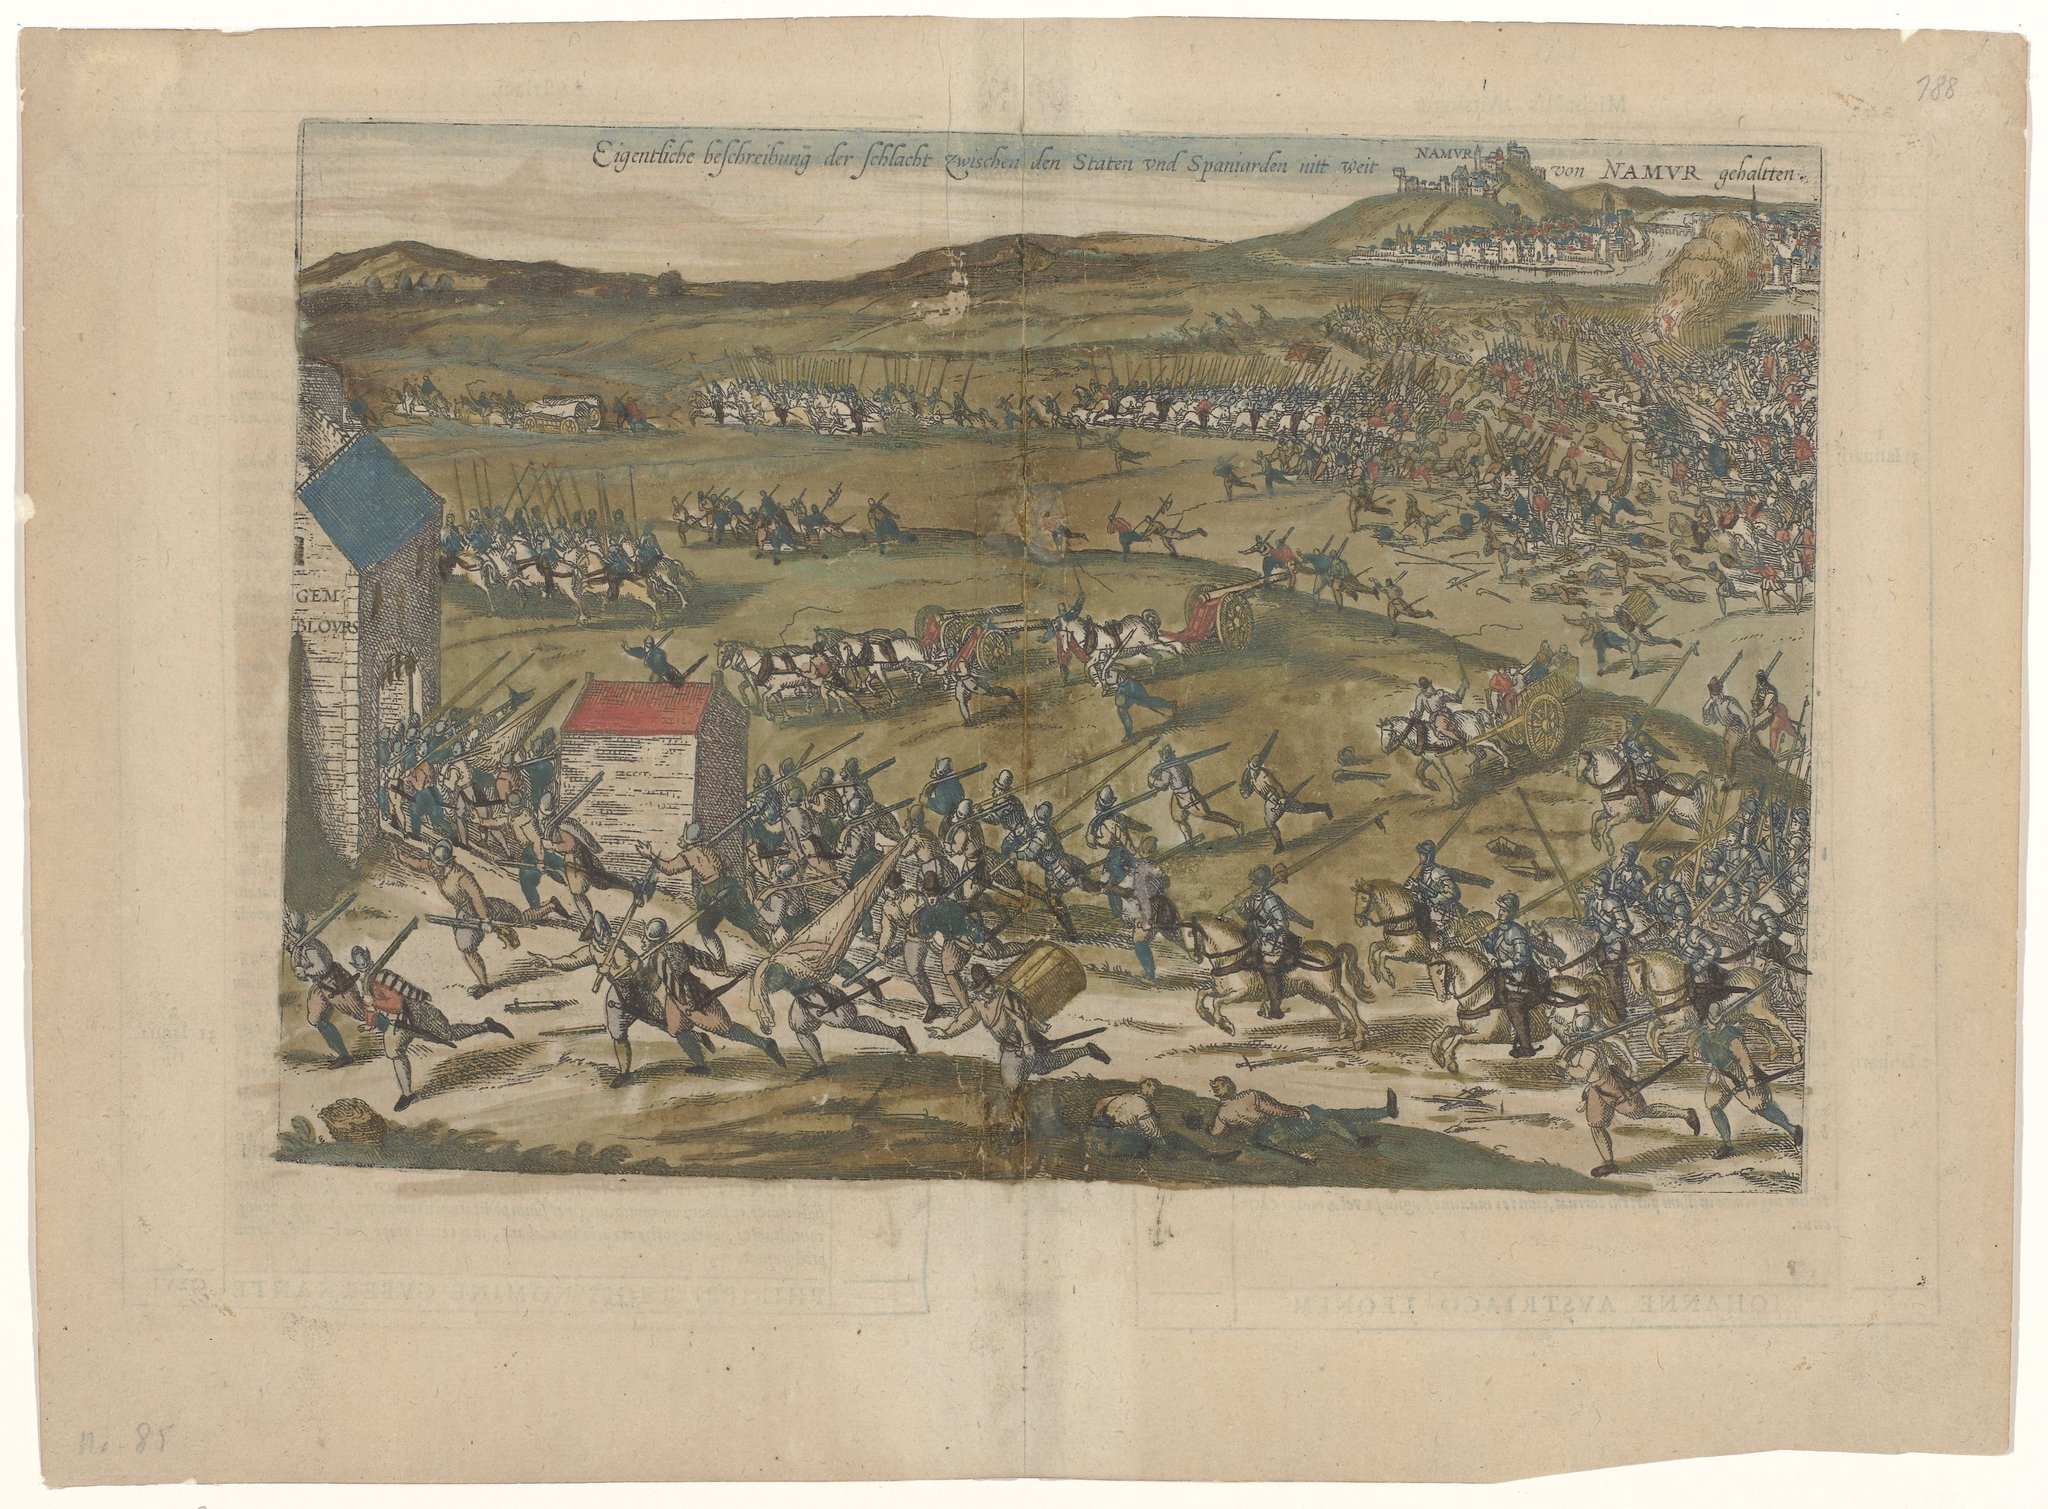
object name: print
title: Serie 8: Nederlandse Gebeurtenissen, 1577-1583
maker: frans hogenberg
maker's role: print maker, publisher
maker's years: 1538-1590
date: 1588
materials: paper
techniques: etching, hand coloring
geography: cologne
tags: battle (+ land forces)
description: Slag bij Gembloers, 31 januari 1578. Veldslag waarbij het Staatse leger verslagen wordt door het leger van Farnese. In de verte de stad Namen. Gedrukt met een cache over het onderschrift.